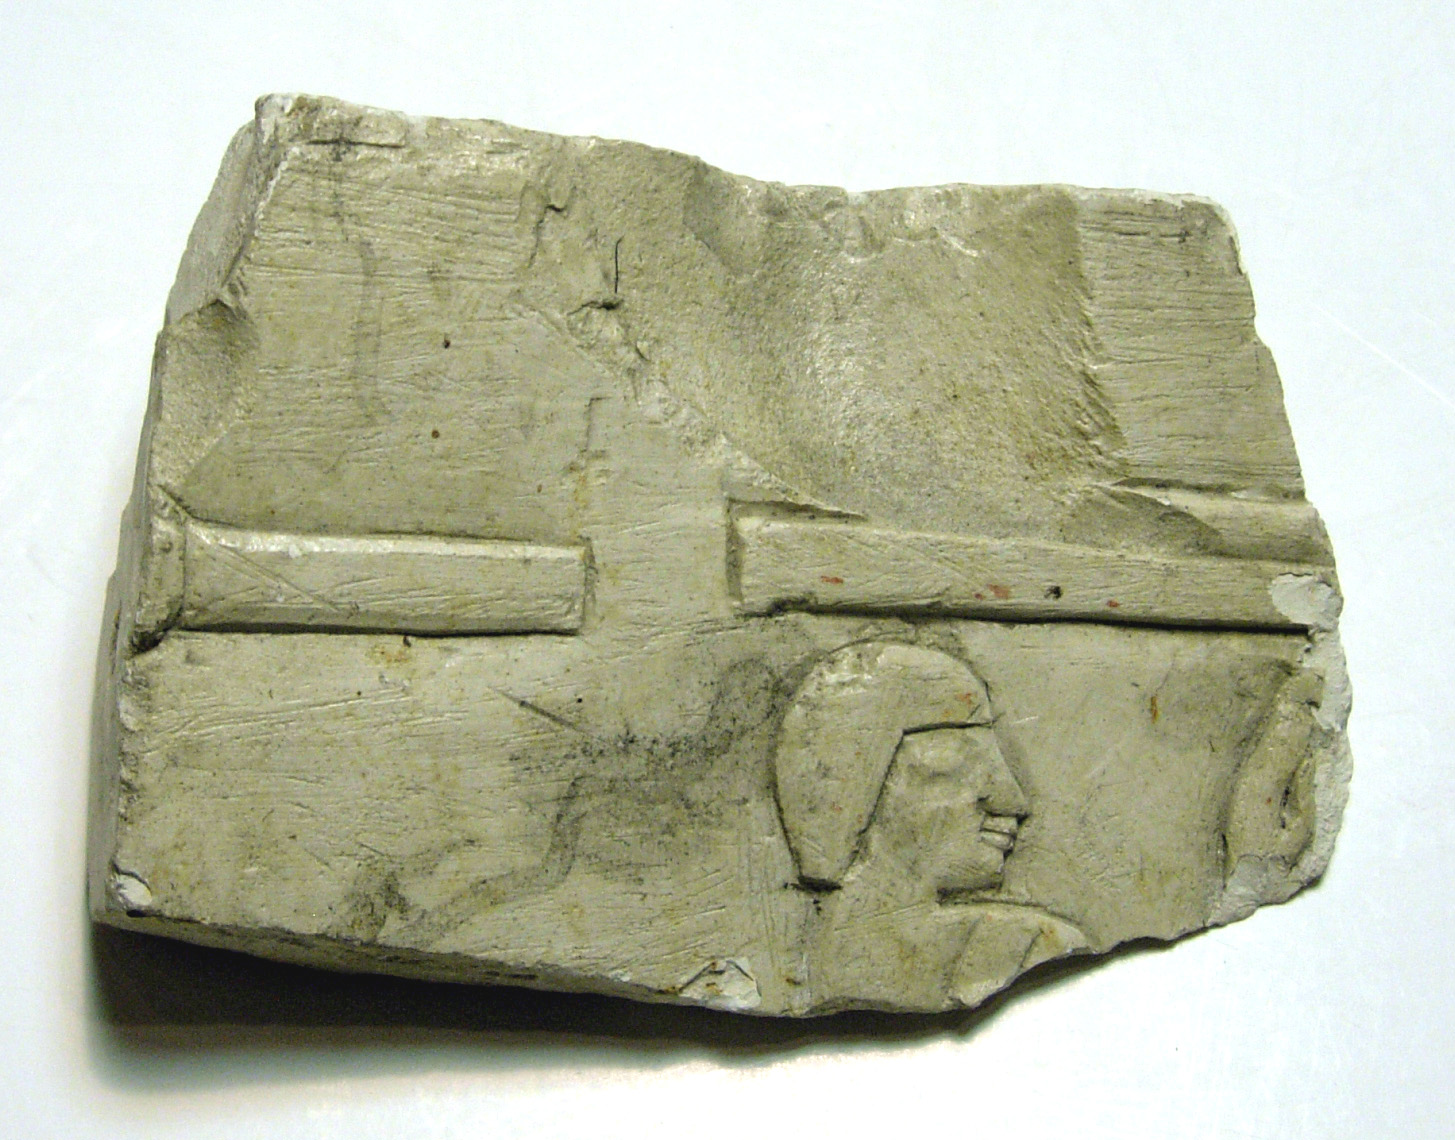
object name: relief, tomb of nespekashuty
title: Raised relief fragment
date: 664-610 BCE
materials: limestone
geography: egypt